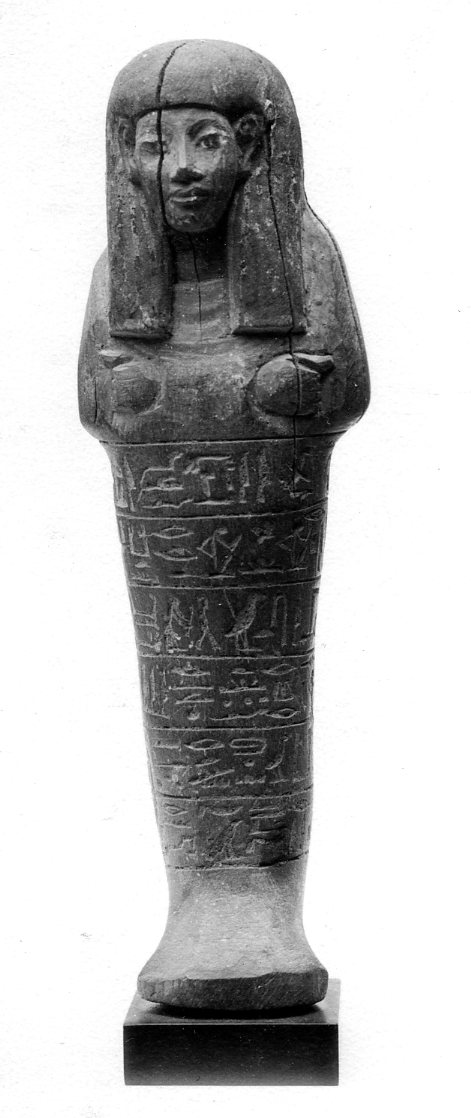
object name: shabti, scribe tjay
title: Shabti of scribe Tjay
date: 1550-1295 BCE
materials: wood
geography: egypt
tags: hieroglyphs